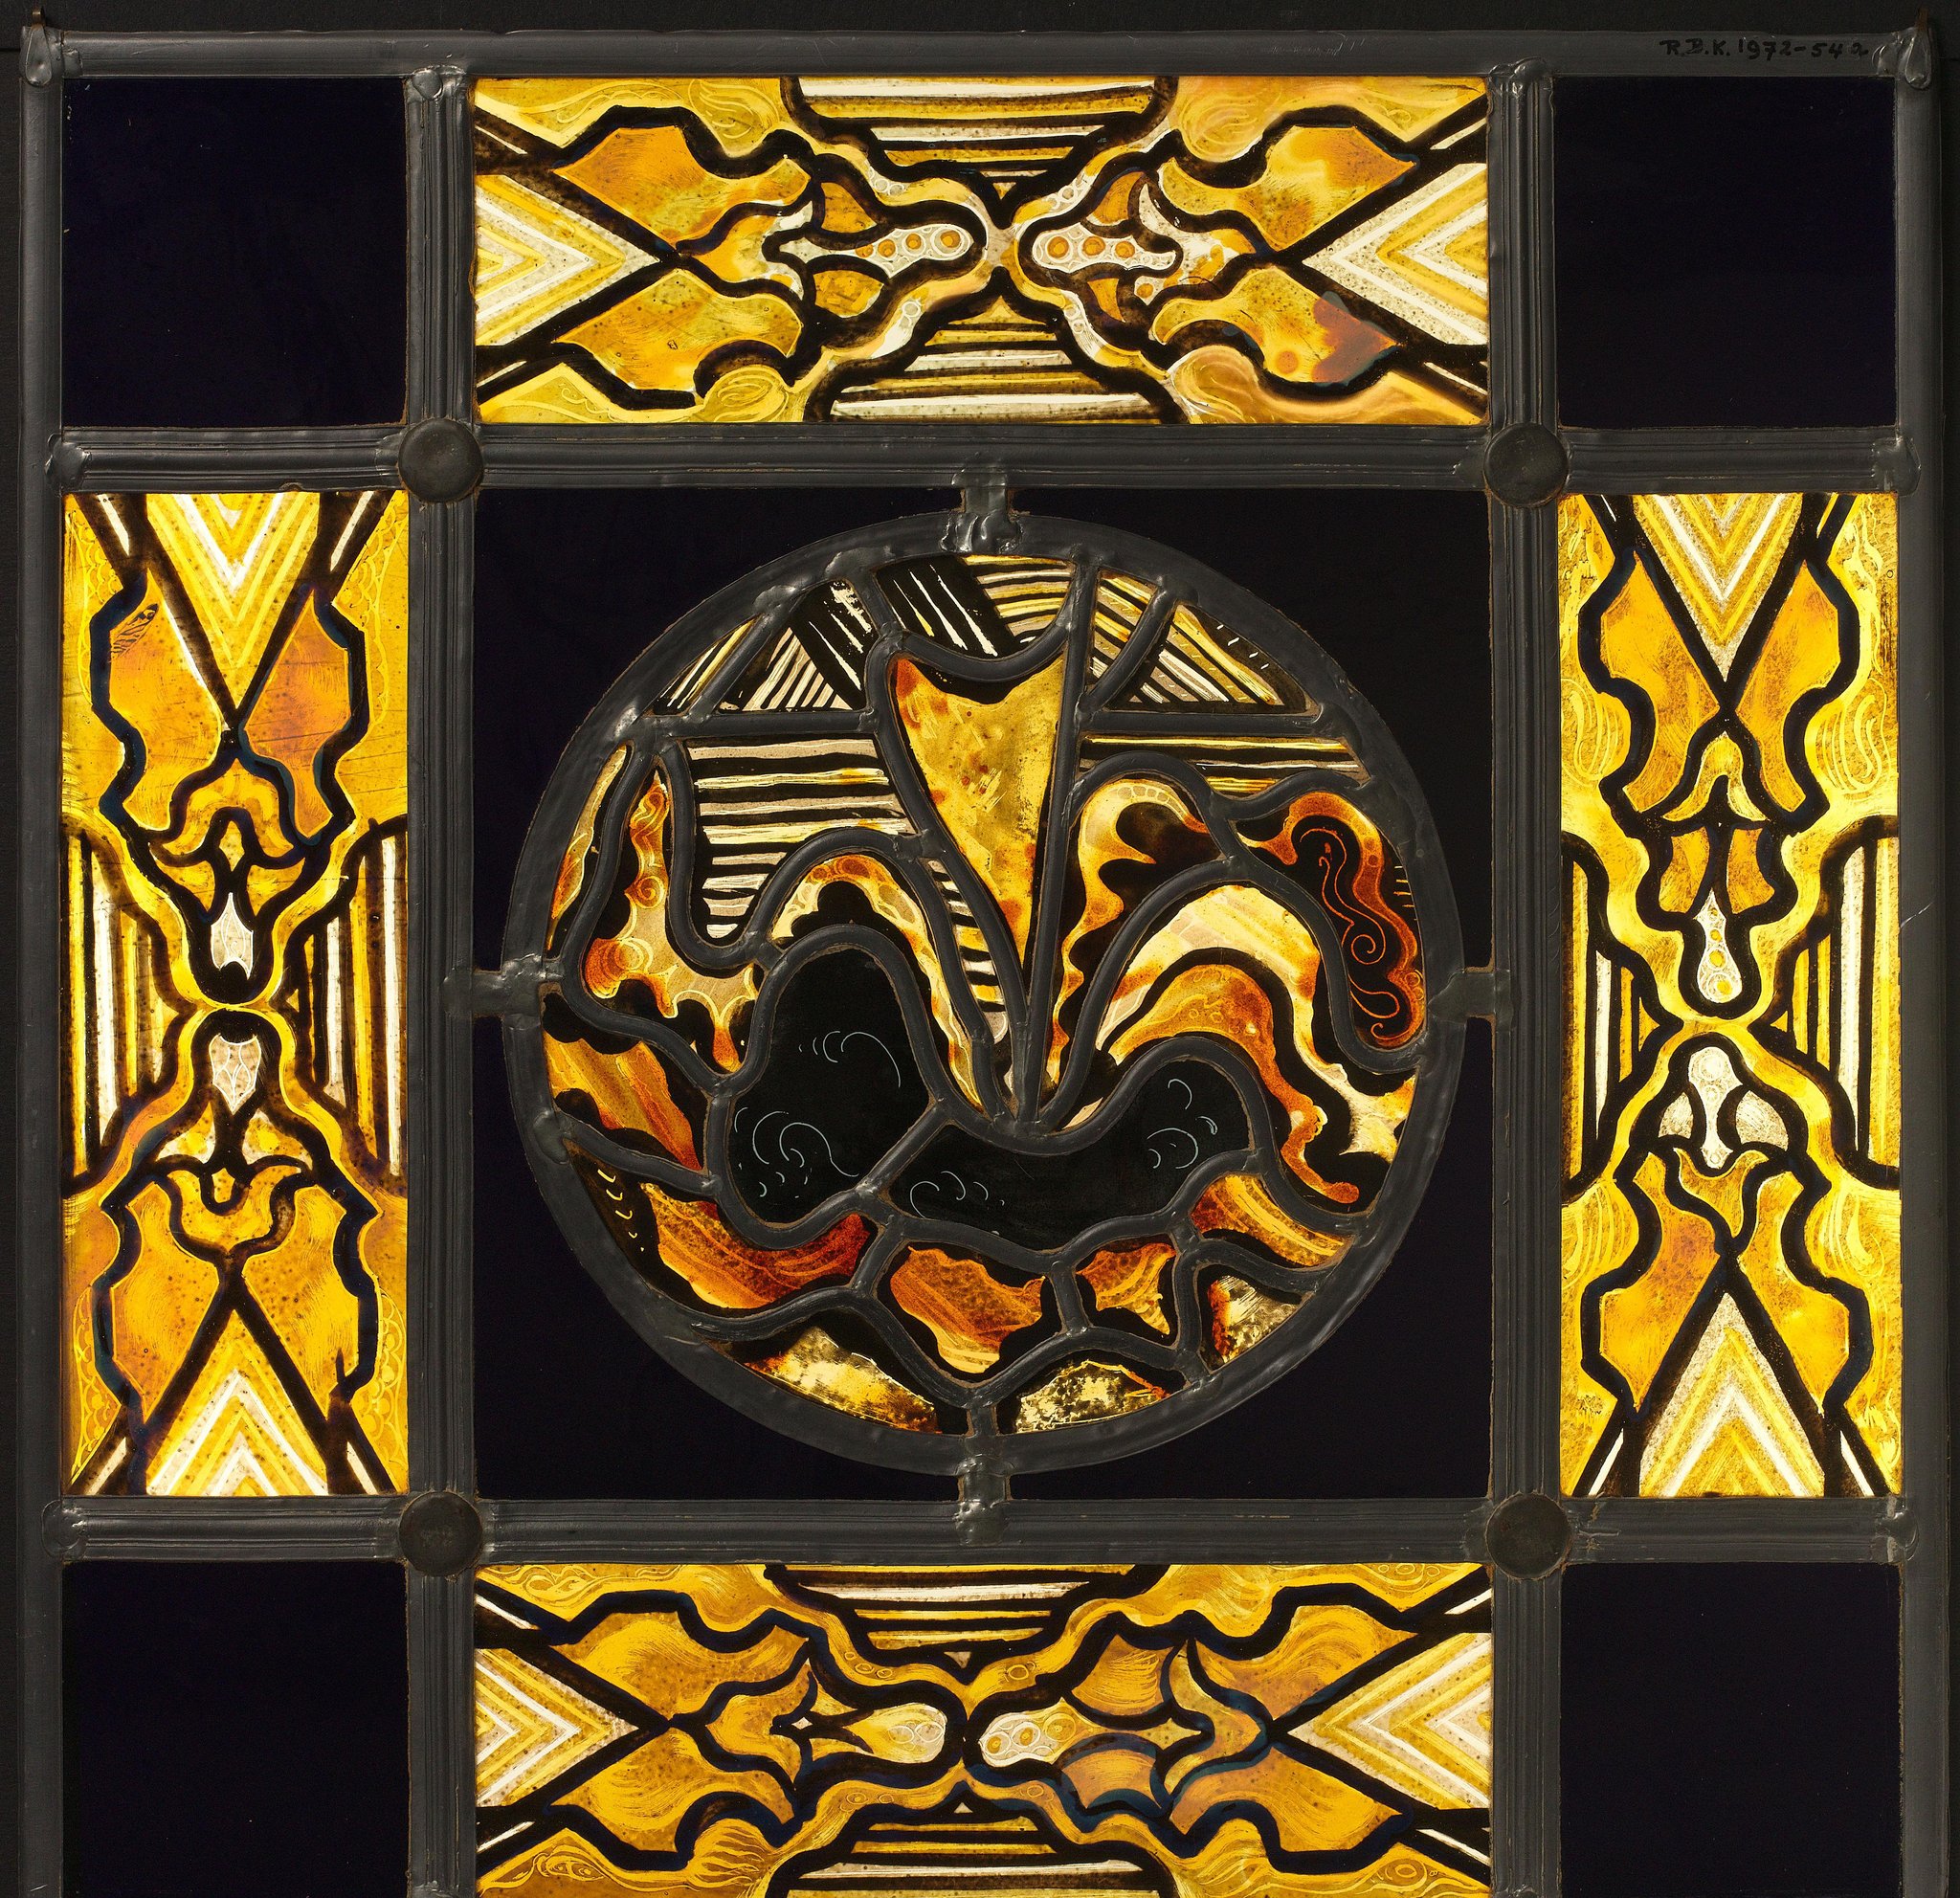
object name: light window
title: Vierkante ruit met in het midden een ronde ruit in geel en donkerbruin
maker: jacoba van heemskerck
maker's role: draughtsman, painter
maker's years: 1876-1923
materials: glass, lead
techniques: leading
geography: domburg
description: Vierkante ruit met in het midden een ronde ruit in geel en donkerbruin.